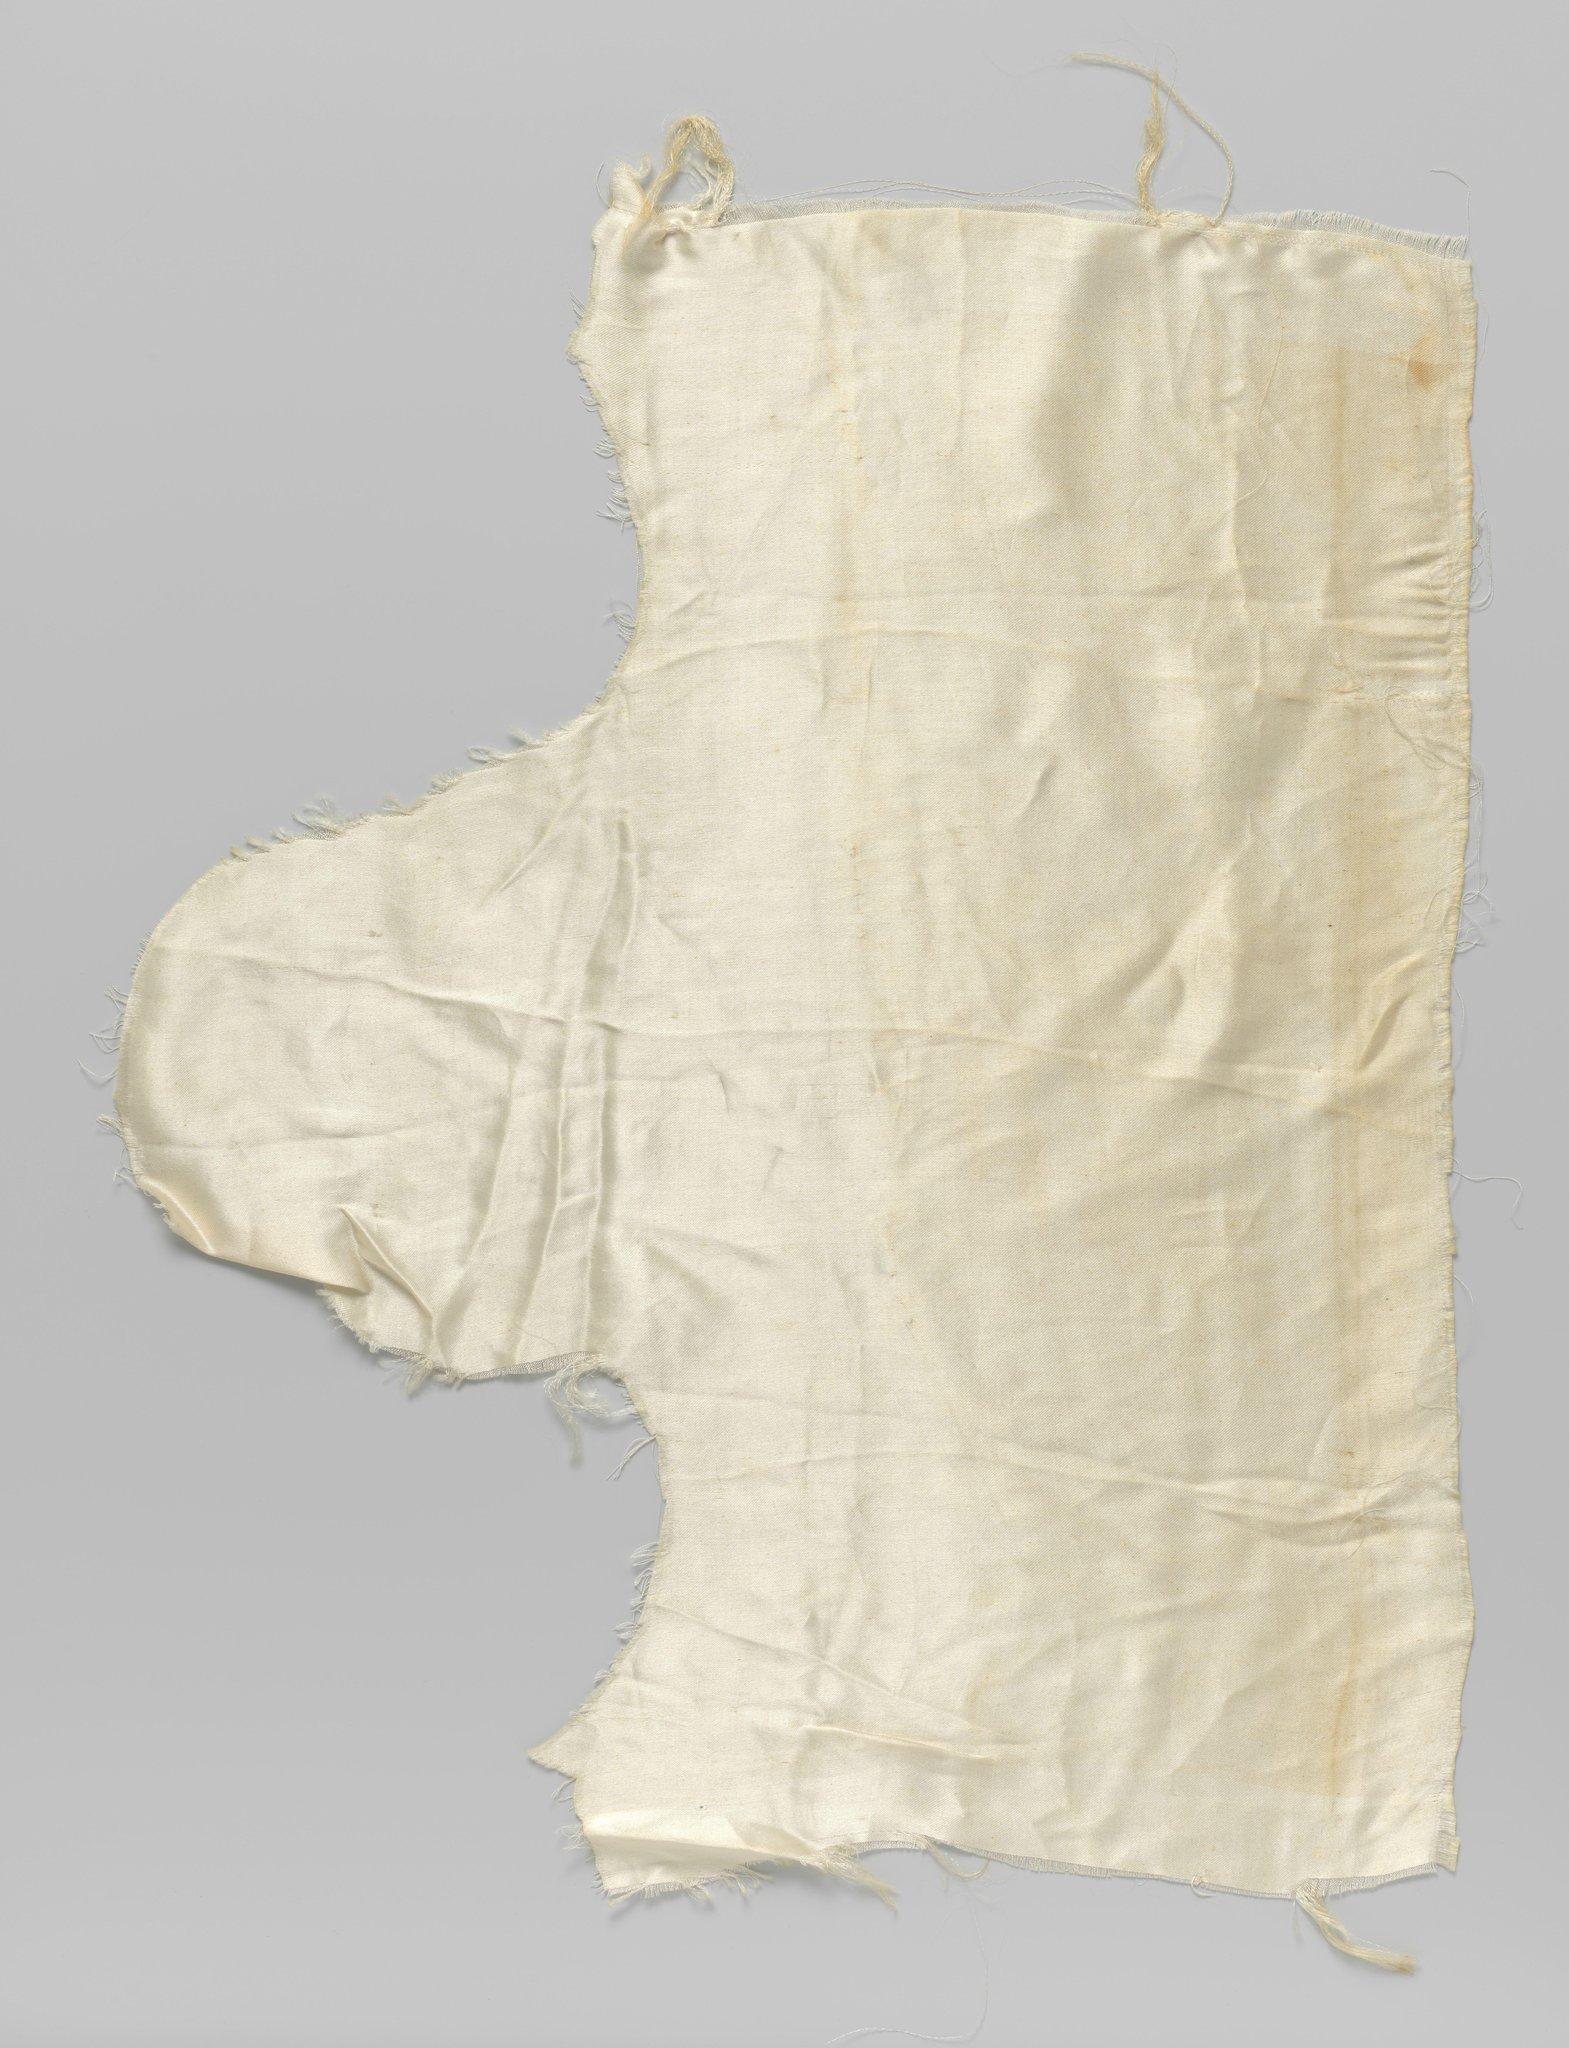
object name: fragment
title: Fragment of coupon van crème satijn; behorende bij een presentatiejapon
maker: mejuffrouw haag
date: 1928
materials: textile, silk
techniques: weave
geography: netherlands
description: Fragment of coupon van crème satijn; behorende bij een presentatiejapon.